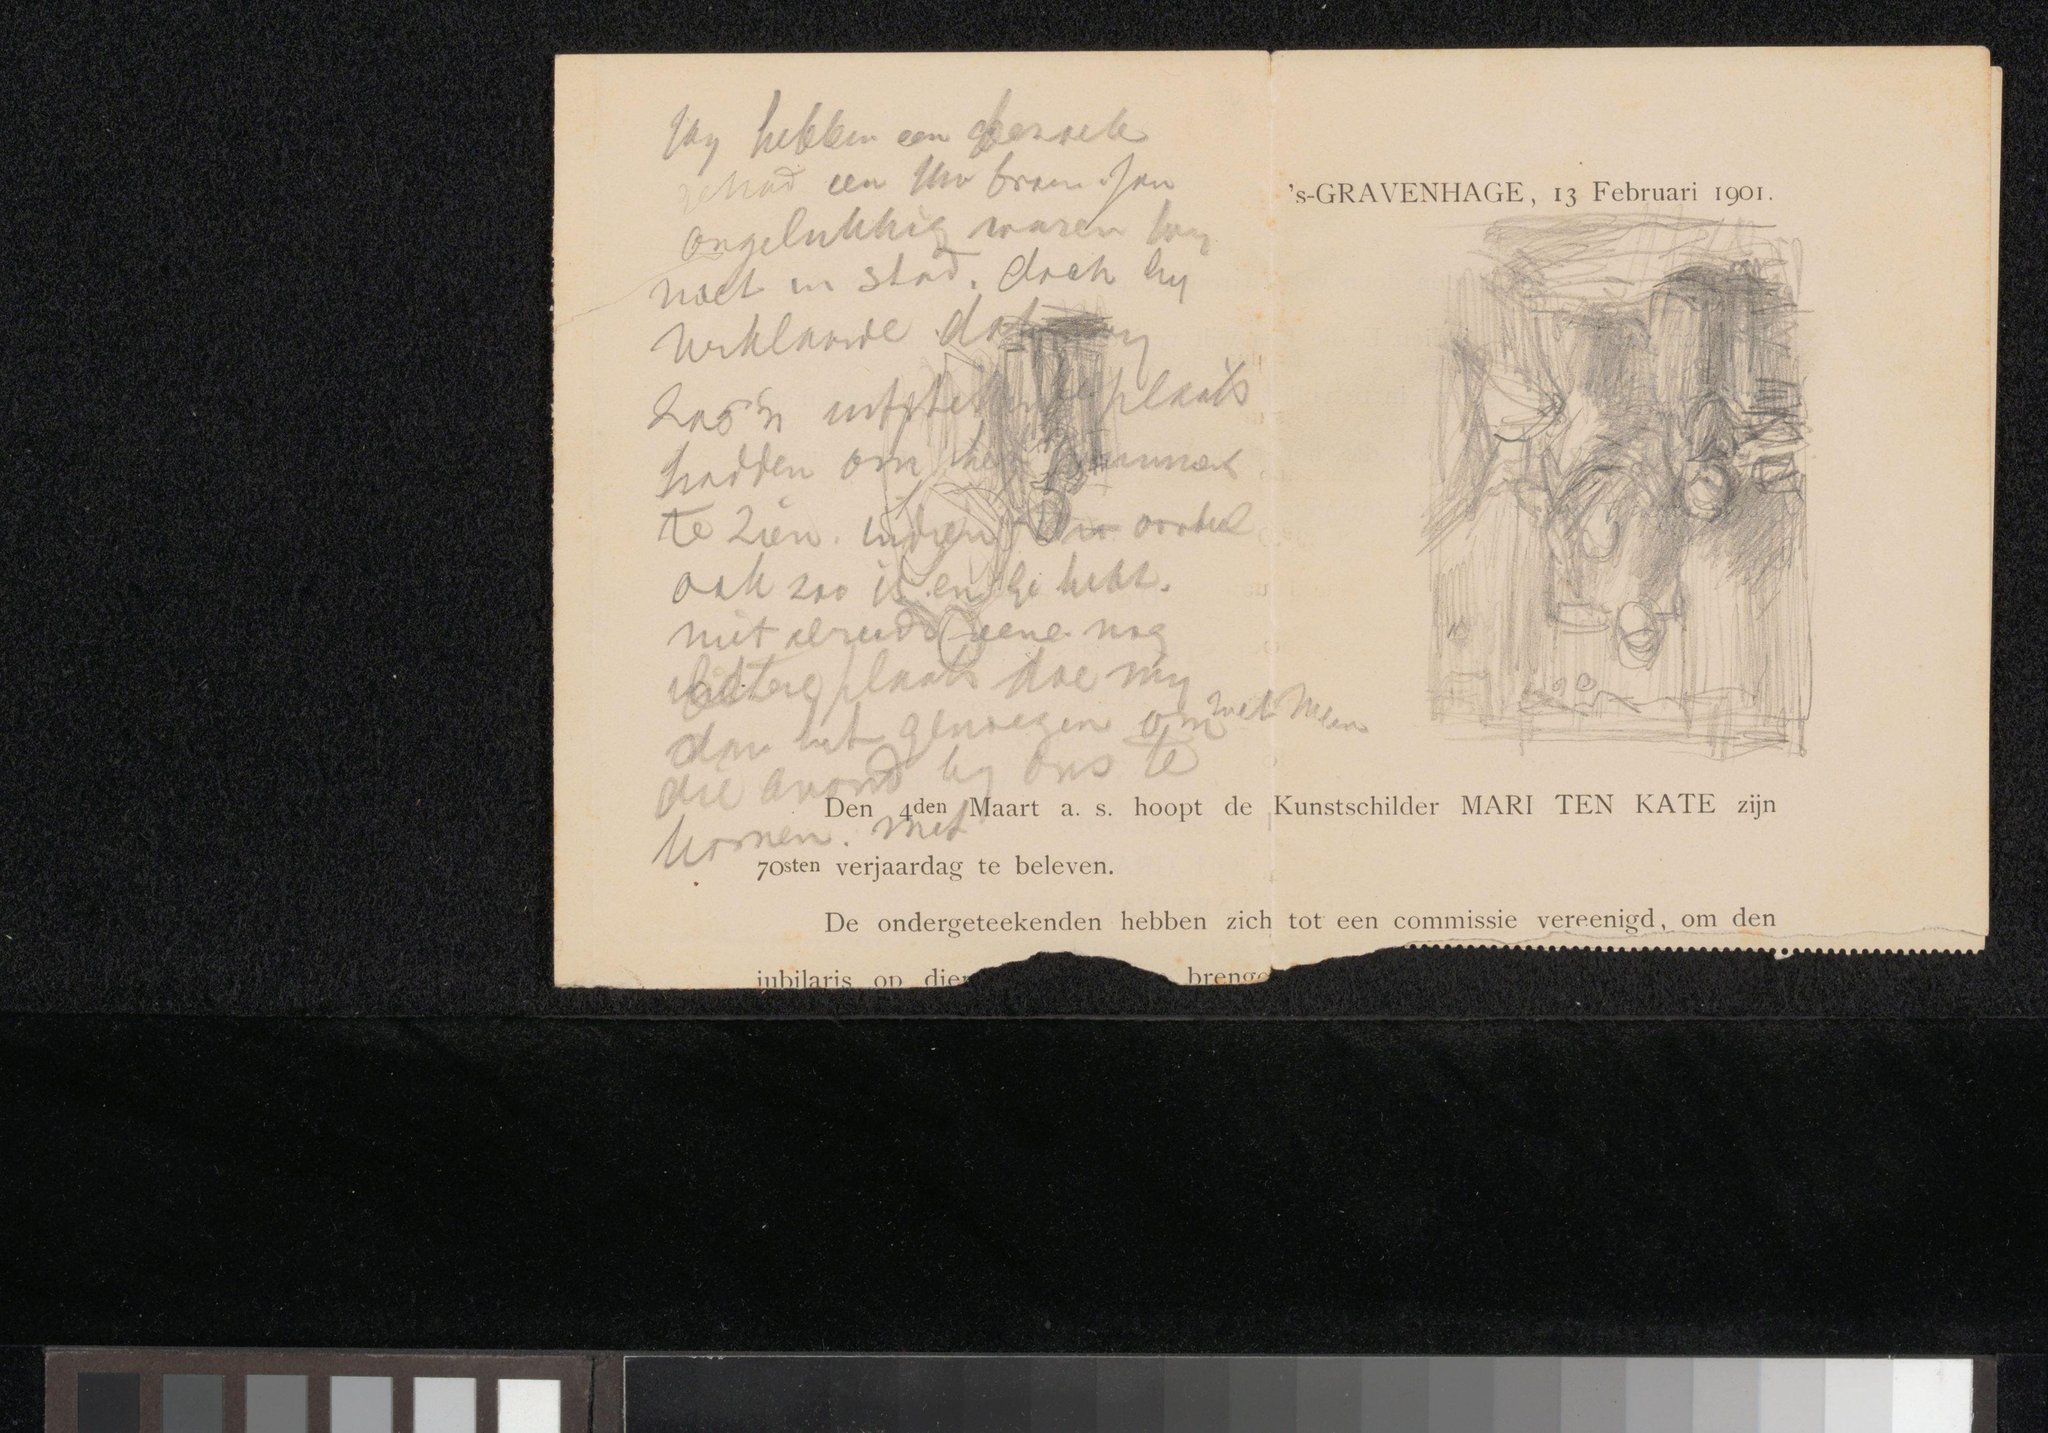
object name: document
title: Circulaire aan Albert Neuhuys (1844-1914)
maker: albert neuhuys (1844-1914)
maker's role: draughtsman, painter, print maker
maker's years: 1844-1914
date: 1901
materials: paper, pencil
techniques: printing, writing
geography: the hague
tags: painter, print maker, draughtsman, mari ten kate, drawing, family life at home, mother and child(ren), woman and child(ren) (family group)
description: Fragment van een circulaire met vijf schetsen en een aantekening door Albert Neuhuys (1844-1914).